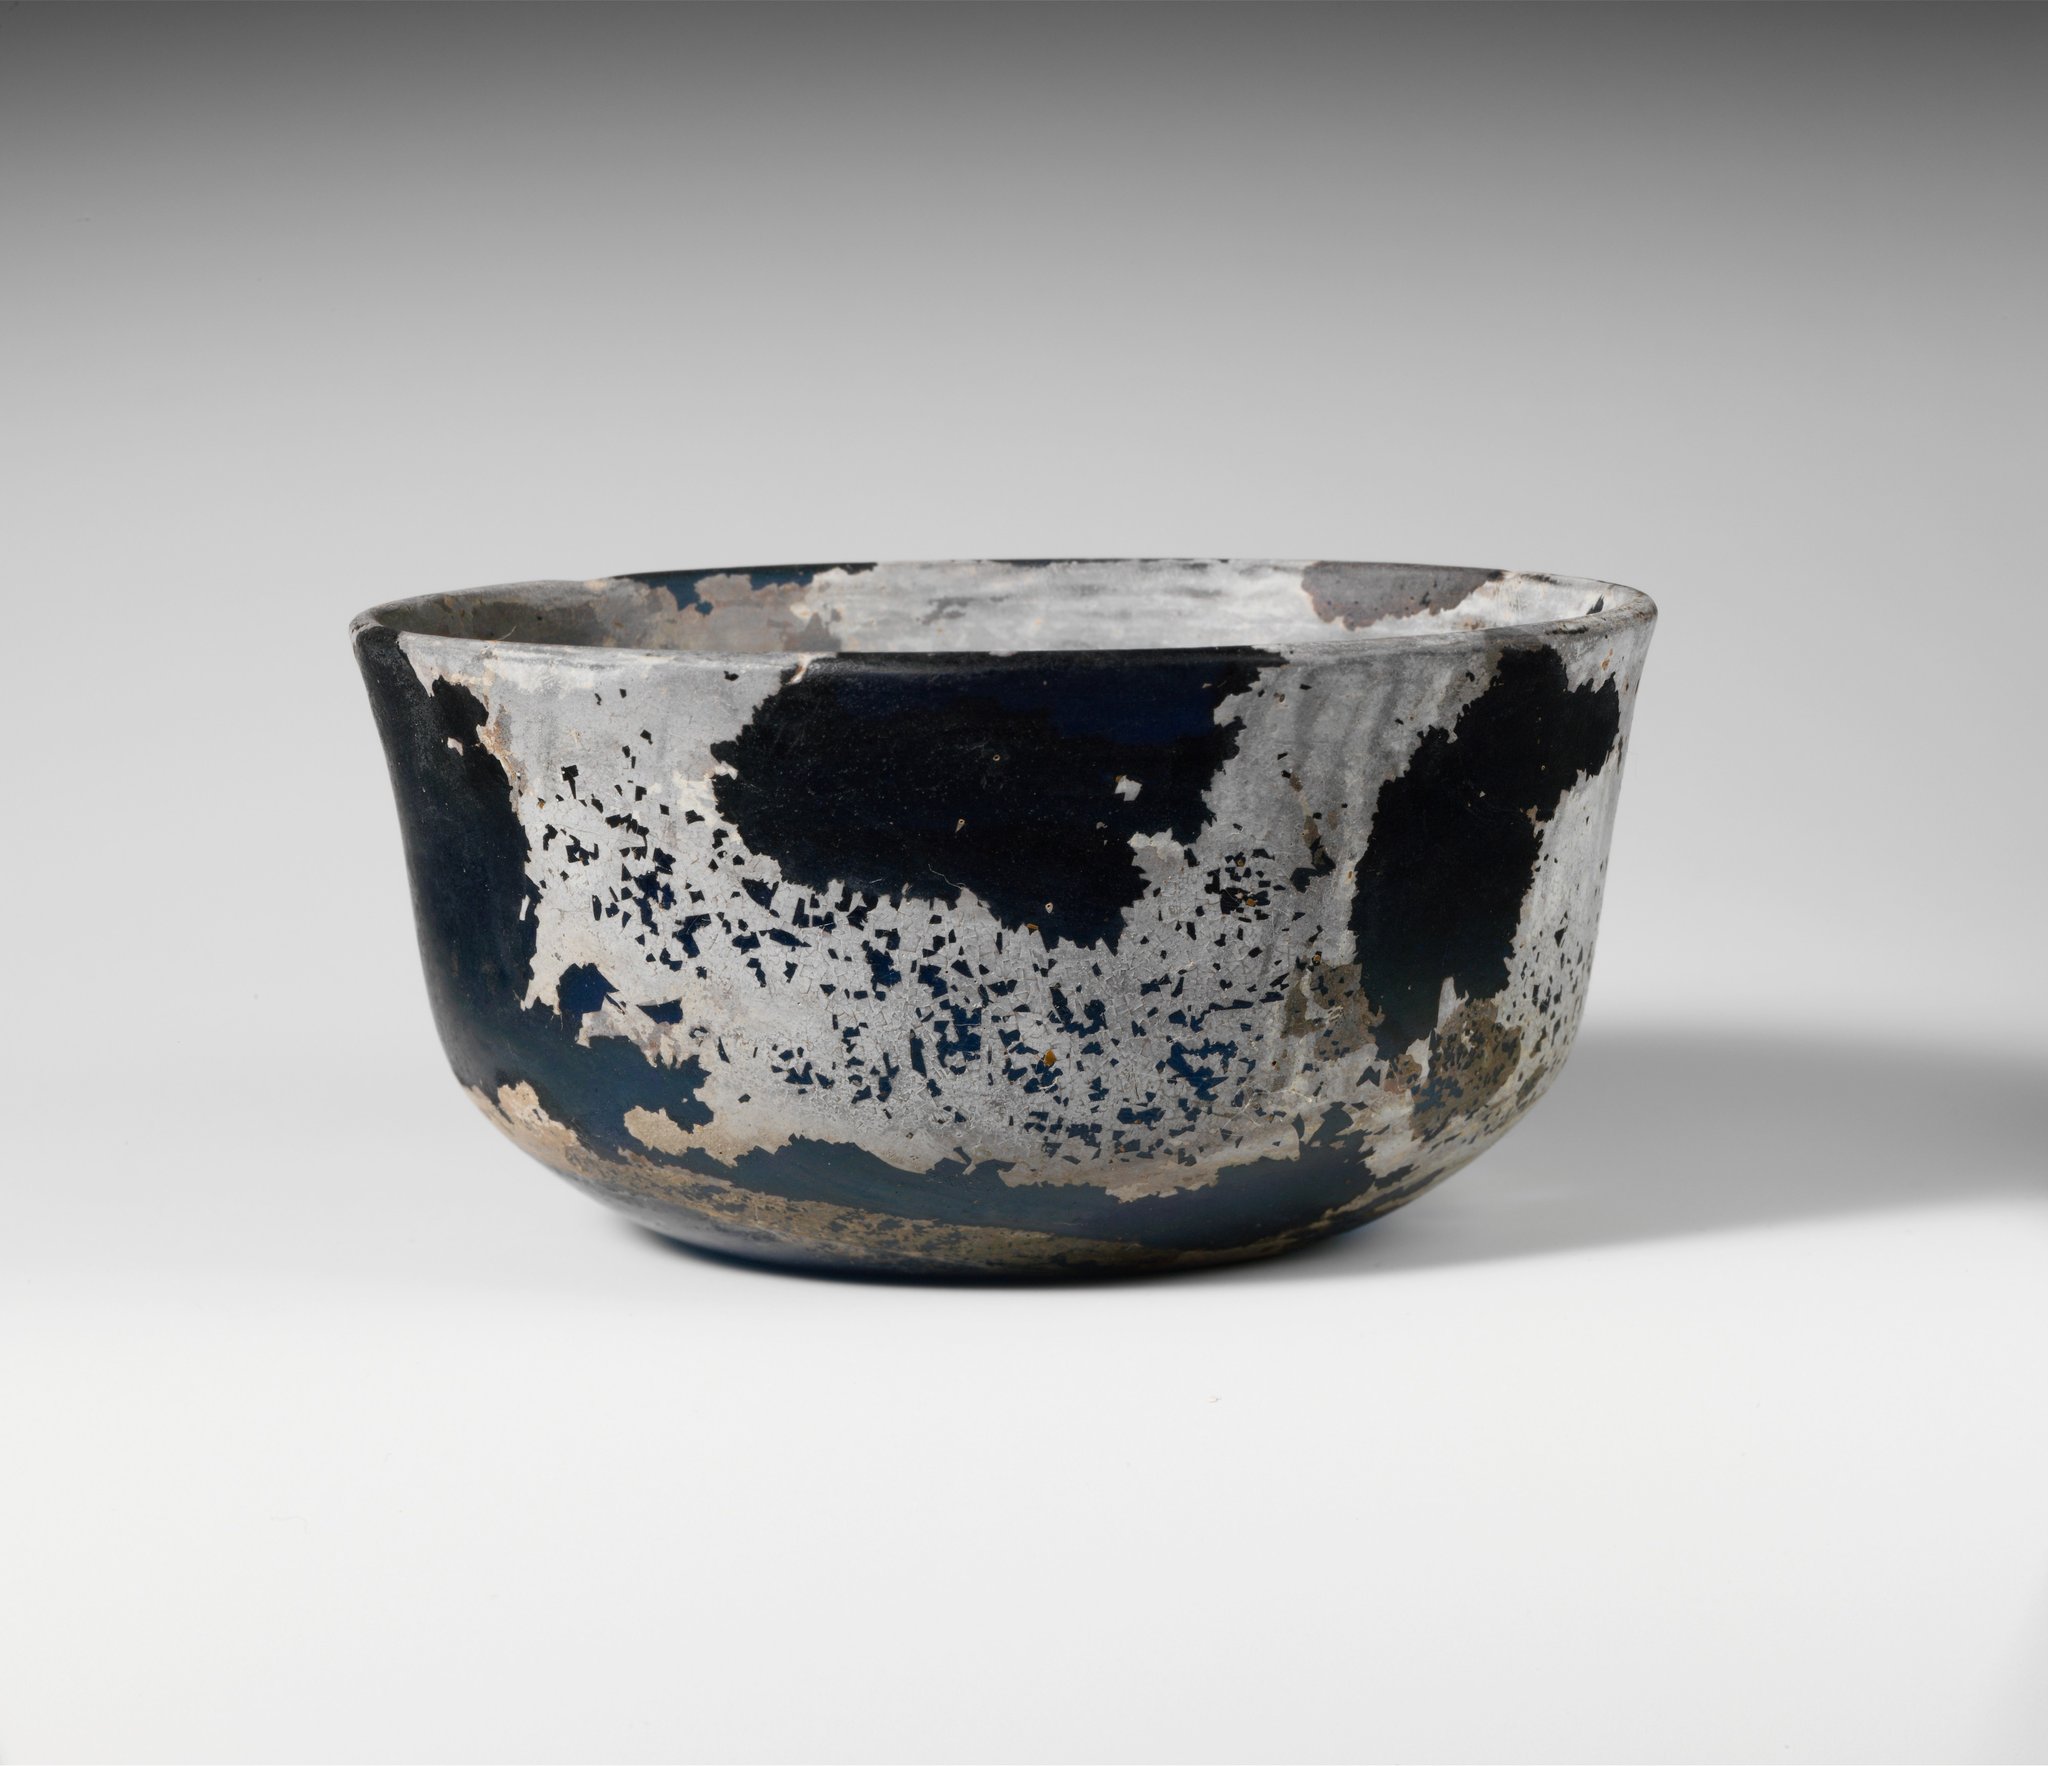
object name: bowl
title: Glass bowl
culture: roman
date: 34 BCE-33 CE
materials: glass